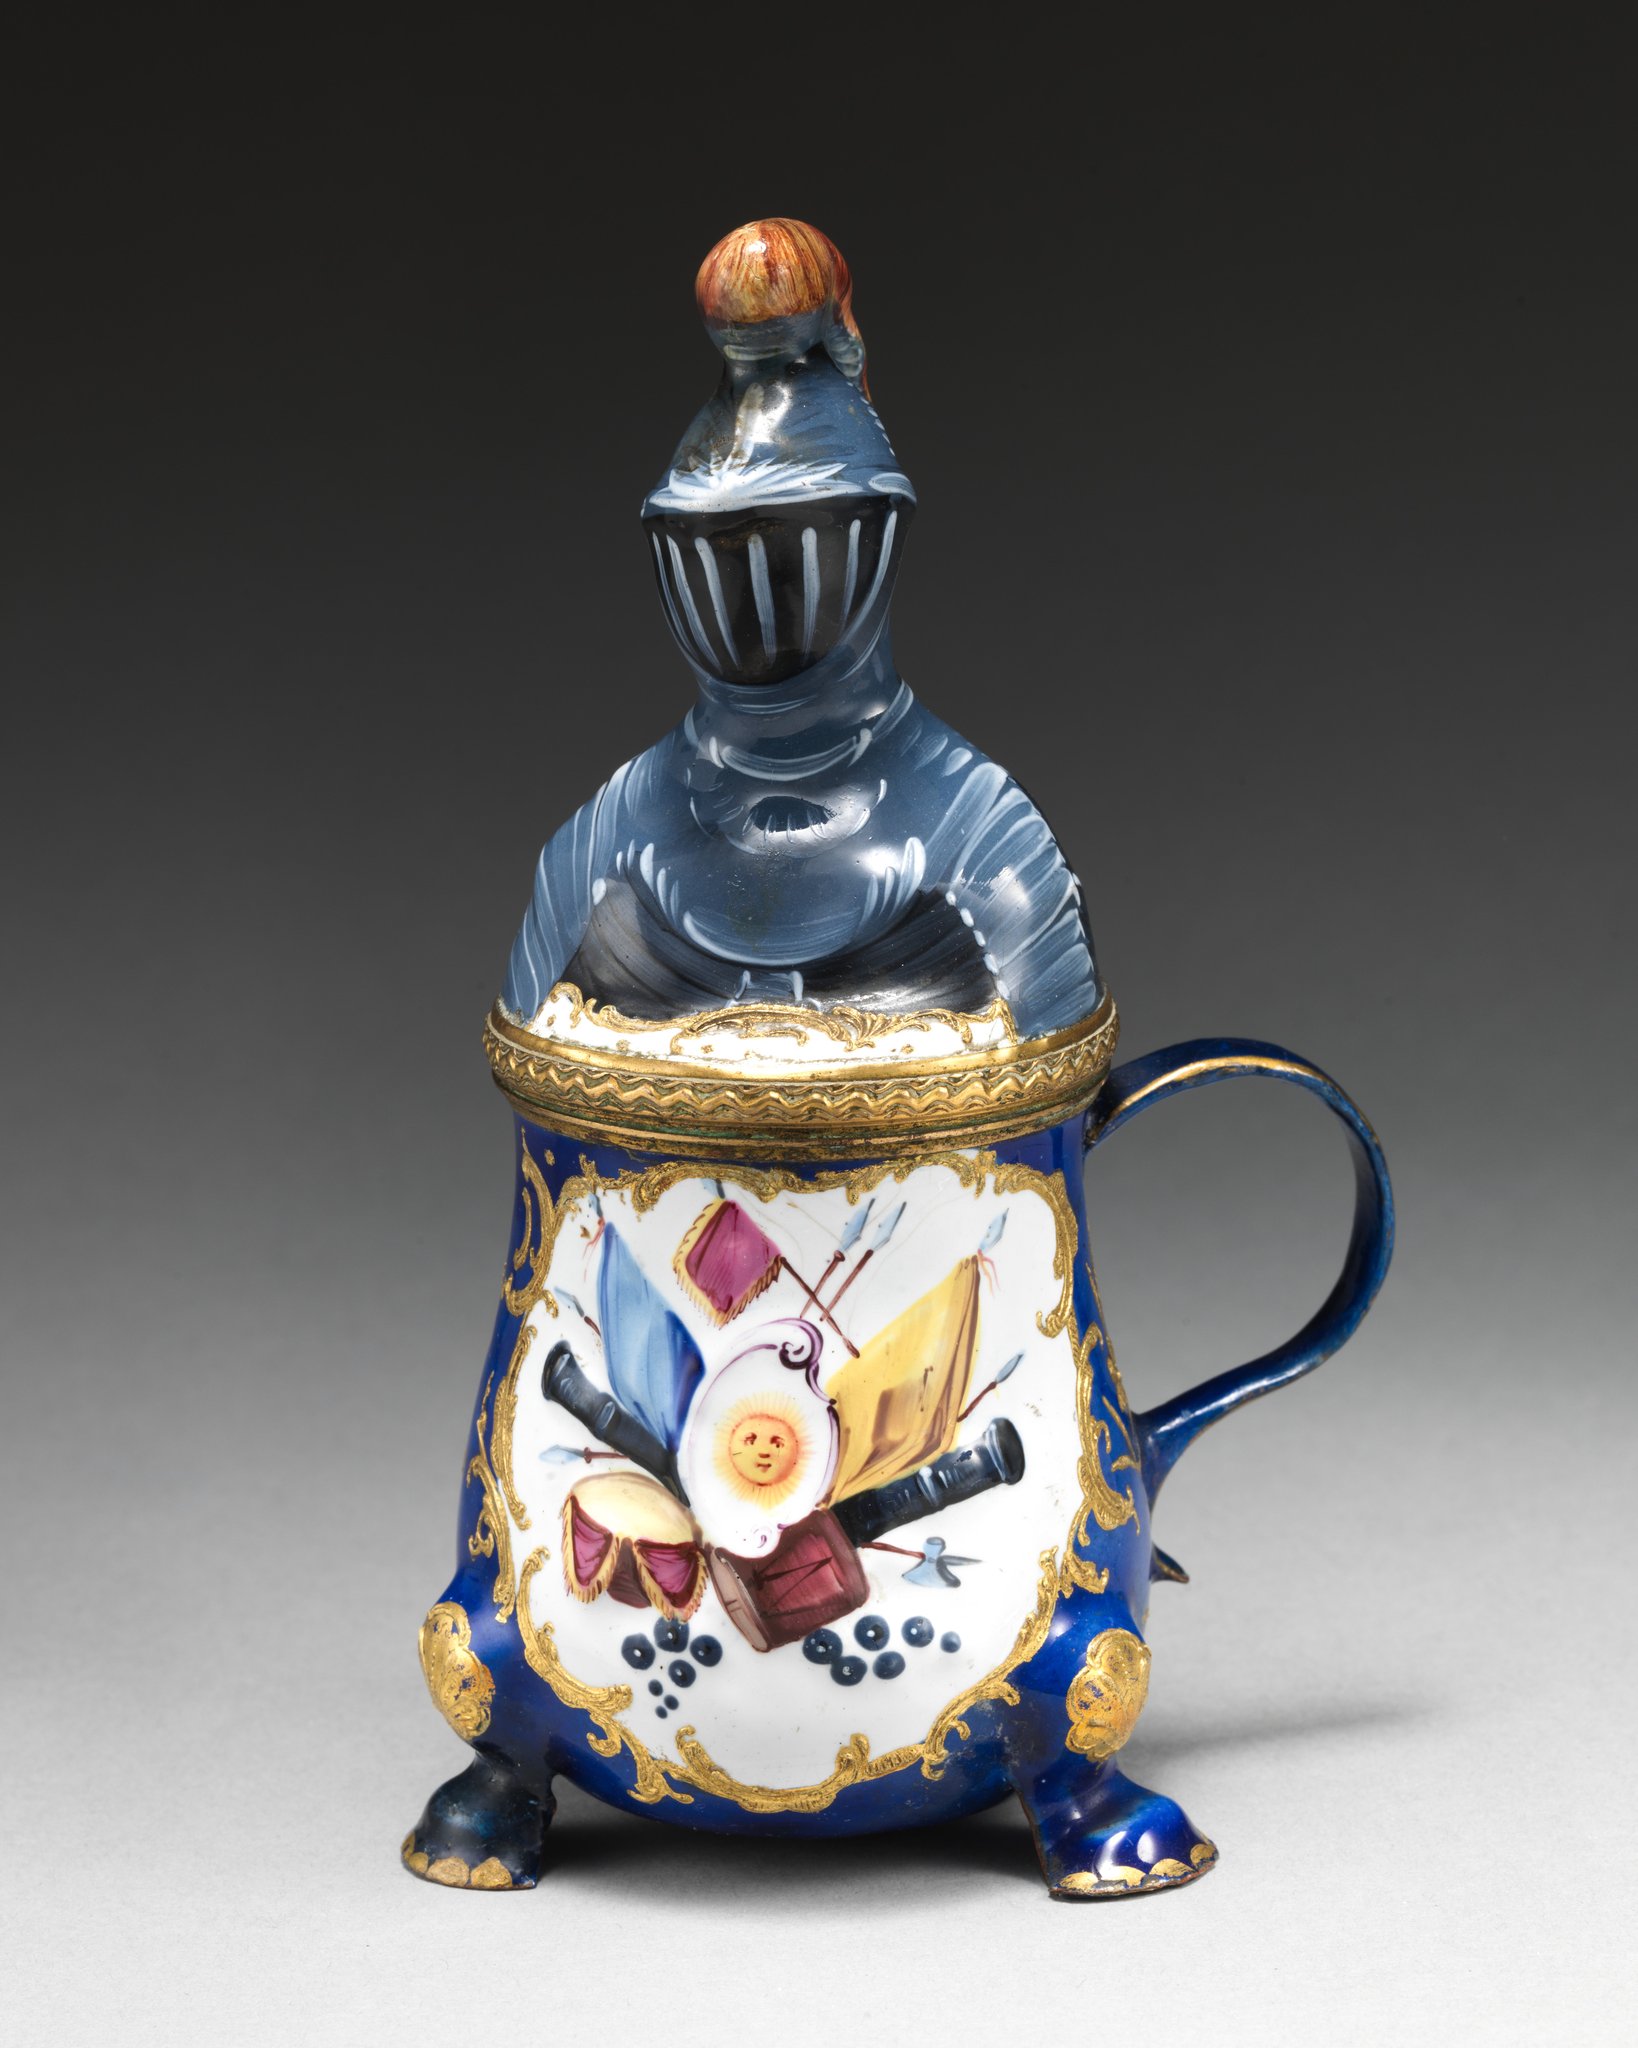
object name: mustard pot with cover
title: Mustard pot with knight-shaped cover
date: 1770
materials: copper, enamel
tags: cannons,drums,flags